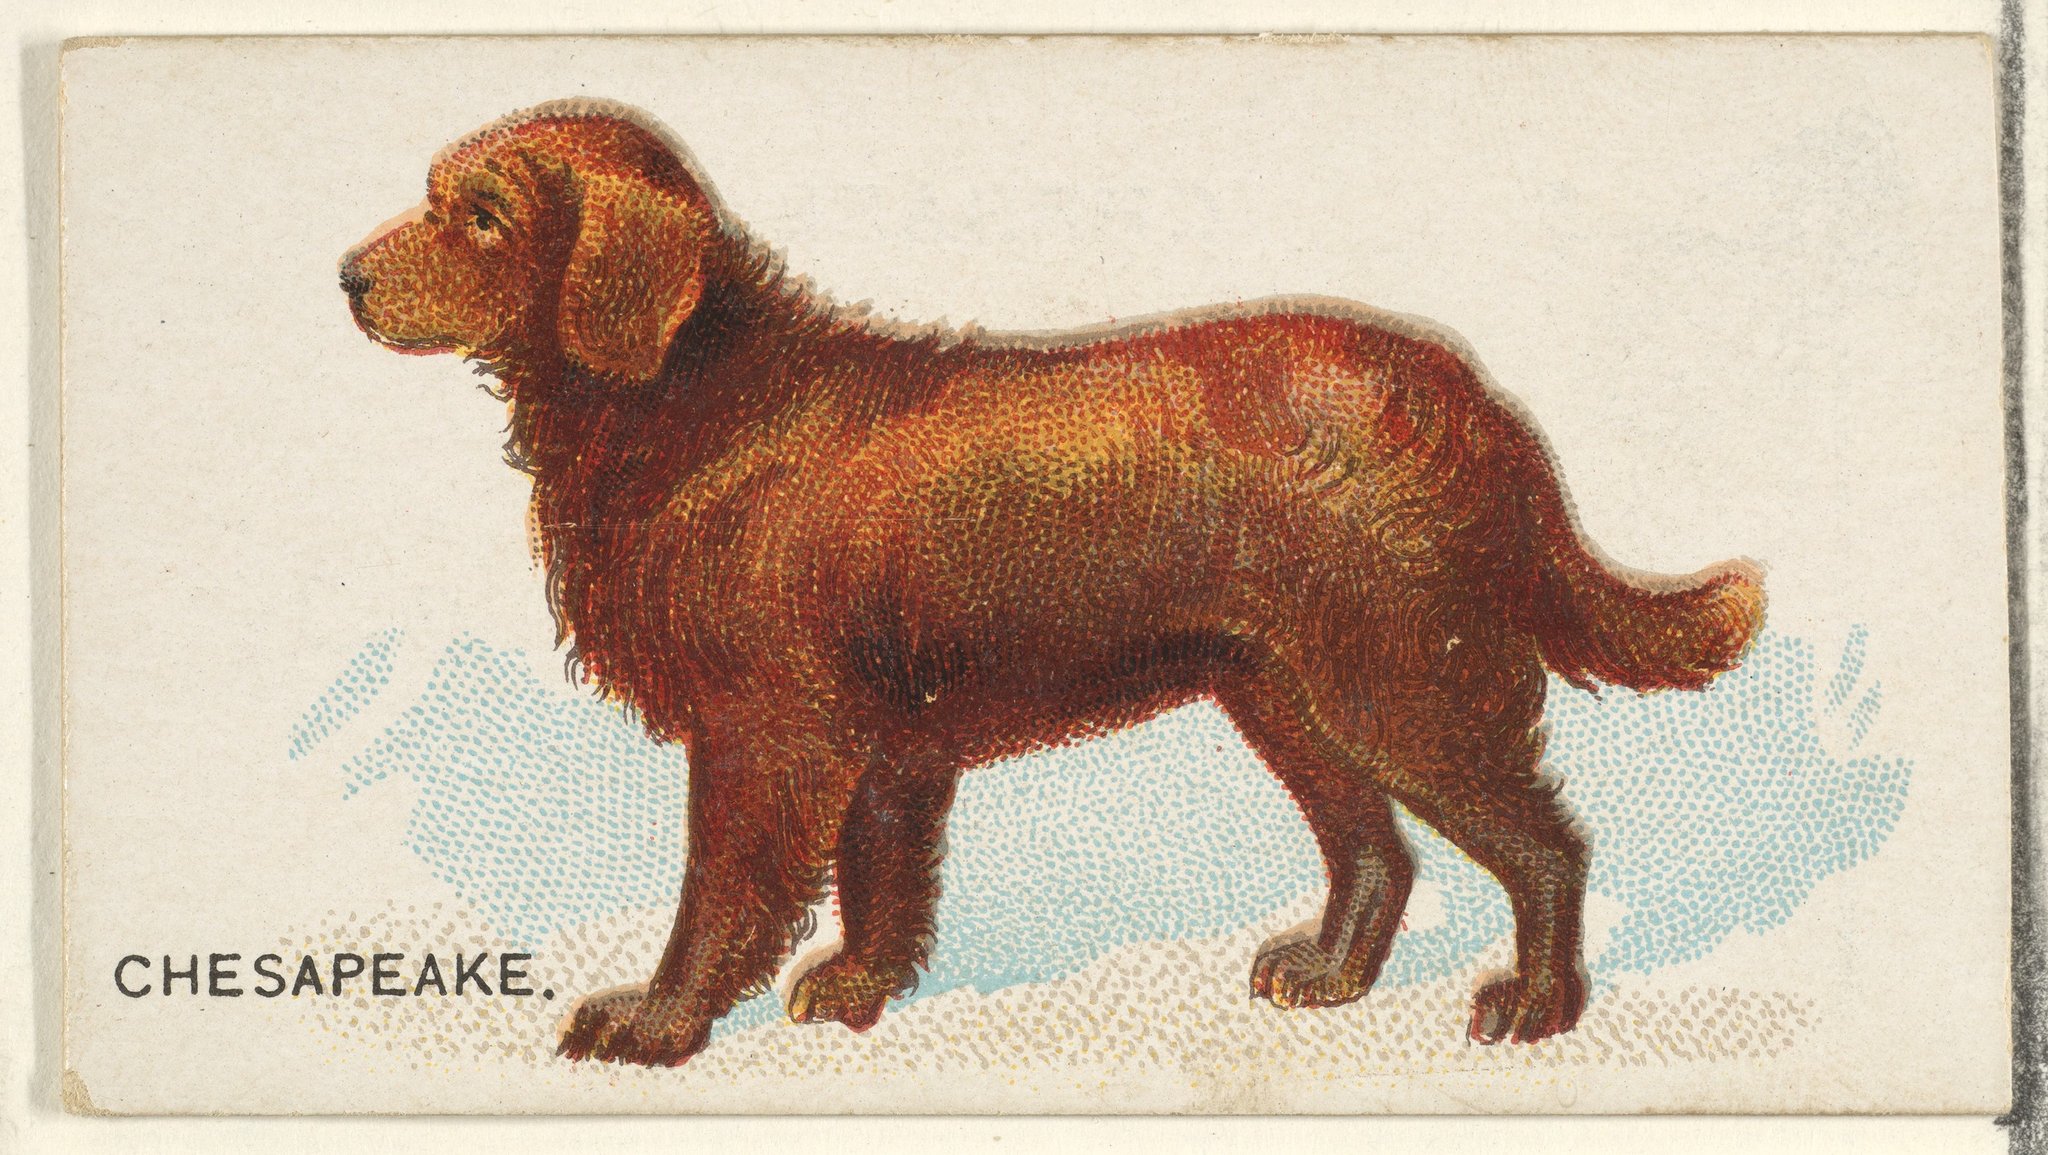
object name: print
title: Chesapeake, from the Dogs of the World series for Old Judge Cigarettes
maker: goodwin & company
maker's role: publisher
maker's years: 1850-1950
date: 1890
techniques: color lithograph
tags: dogs